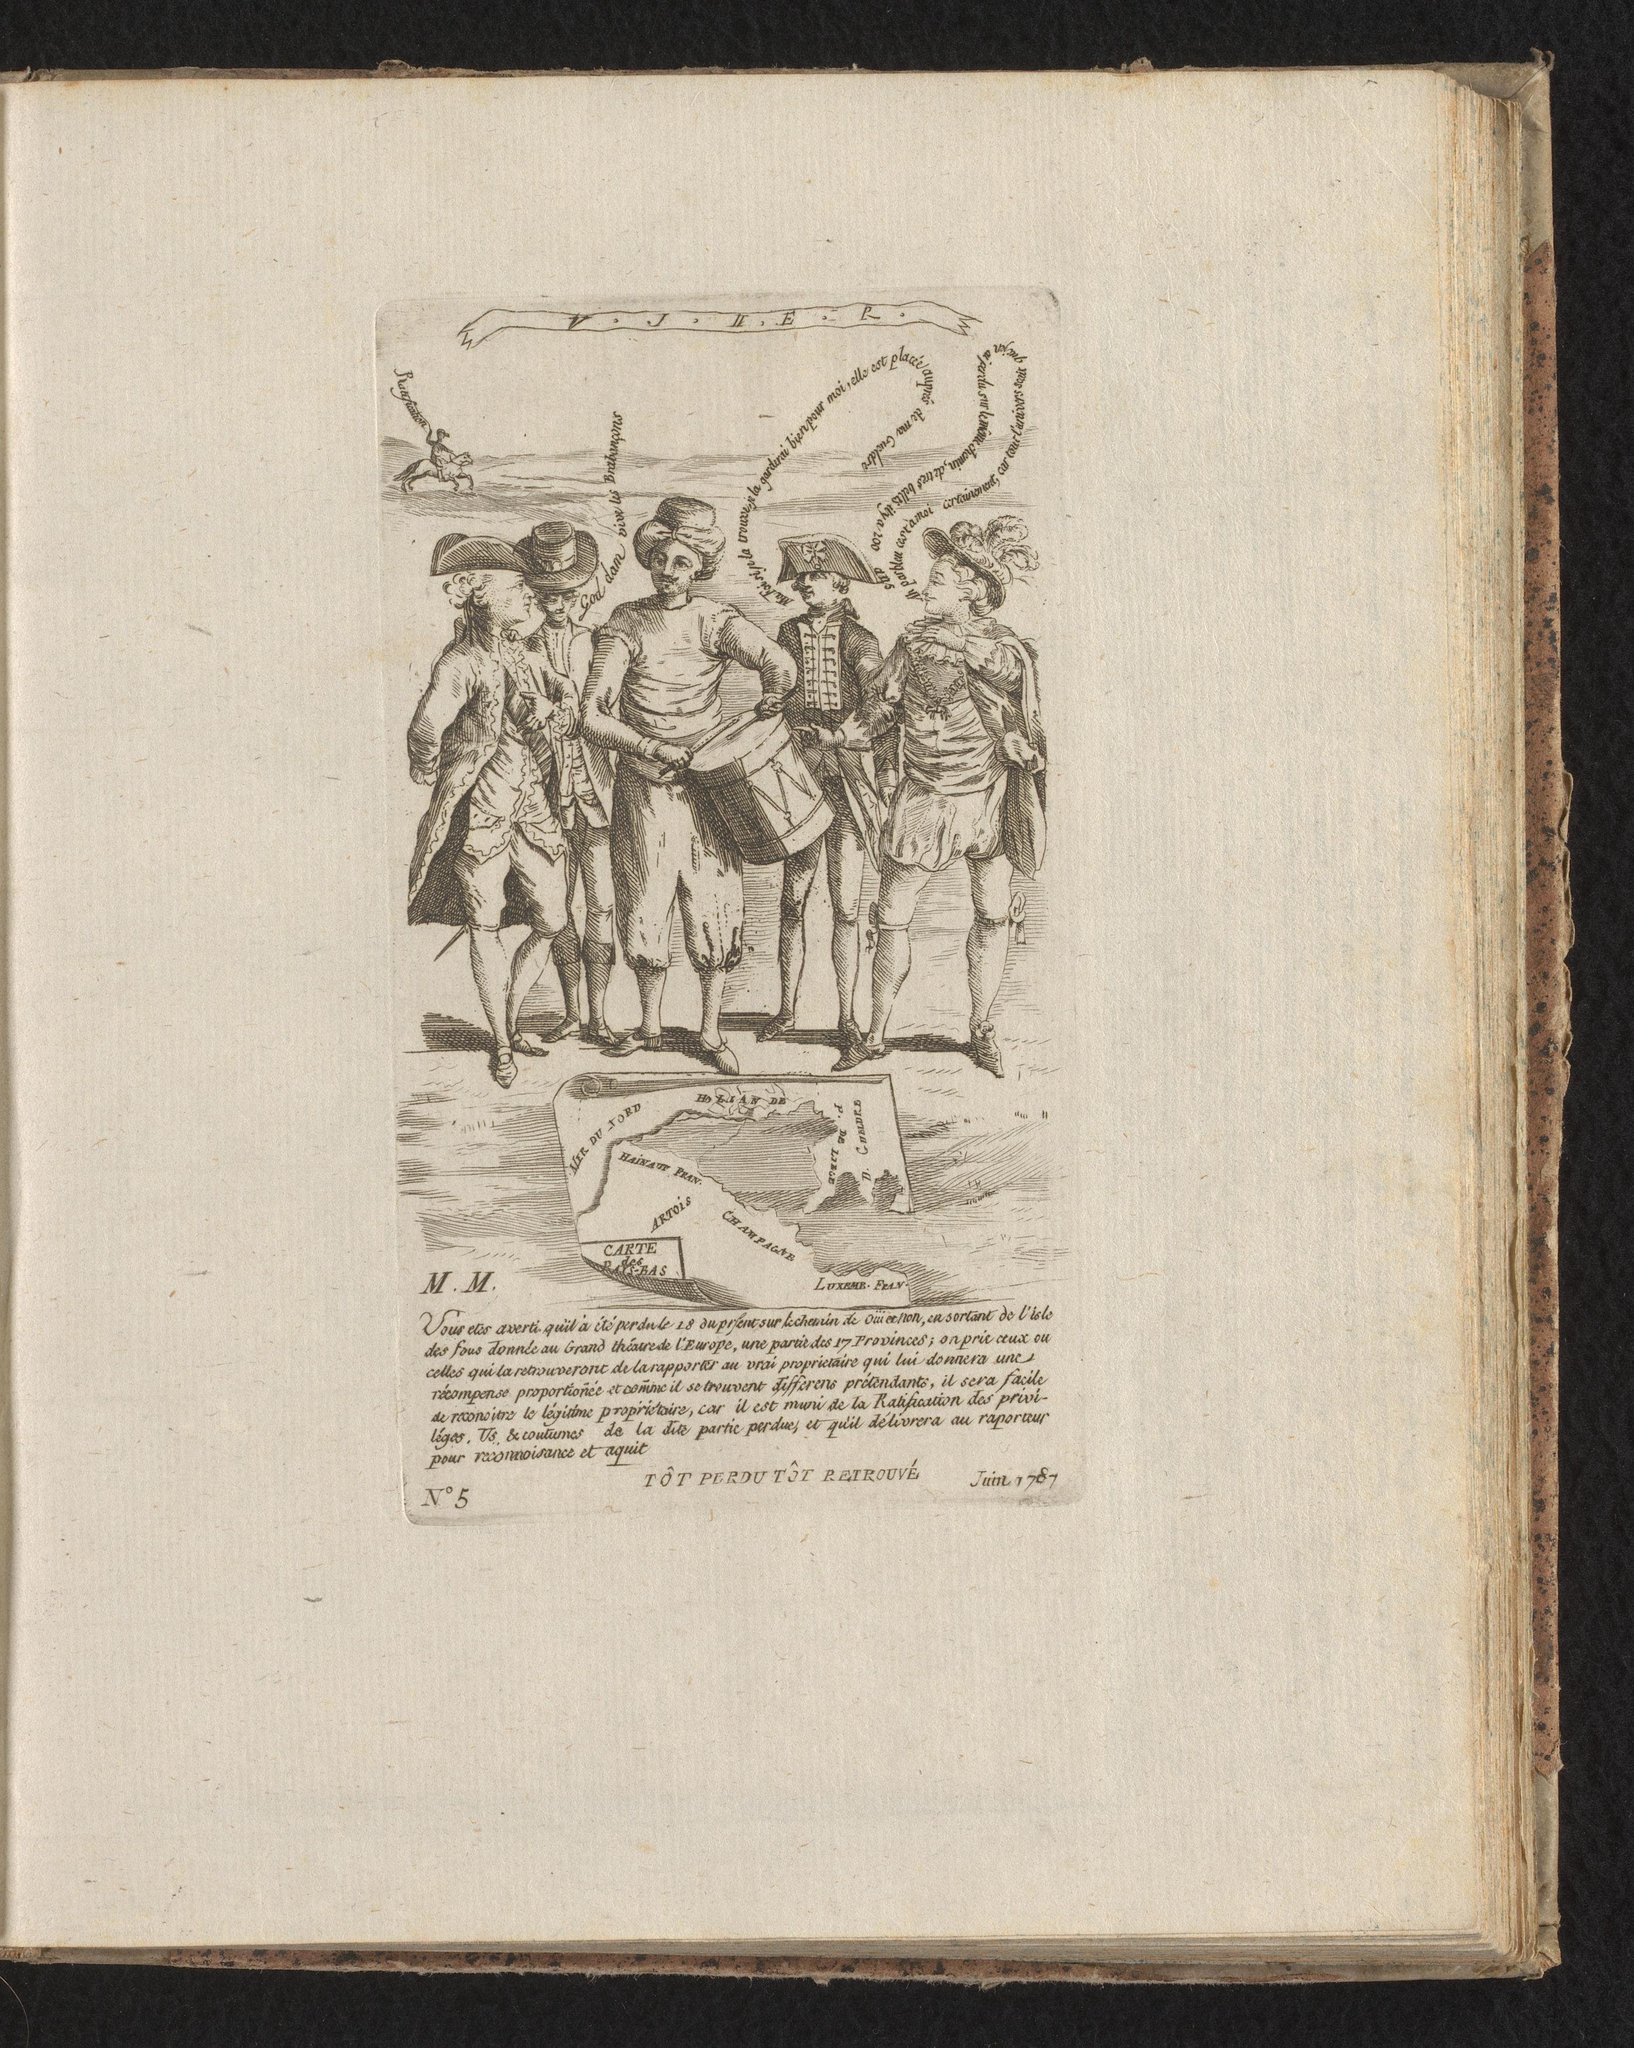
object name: print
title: Tôt Perdu tôt Retrouvé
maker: Anonymous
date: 1787-1790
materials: paper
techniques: engraving, etching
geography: southern netherlands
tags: brabant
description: Vijf mannen staande bij een op de grond liggende kaart waaruit de Oostenrijkse Nederlanden gescheurd zijn. De middelste man speelt op een trommel. Met Frans onderschrift. Heeft betrekking op de gebeurtenissen van juni 1787. Linksonder genummerd: No 5. Onderdeel van de gebundelde verzameling prenten betrekking hebbend op de gebeurtenissen van de Brabantse Omwenteling en de periode 1787-1790.